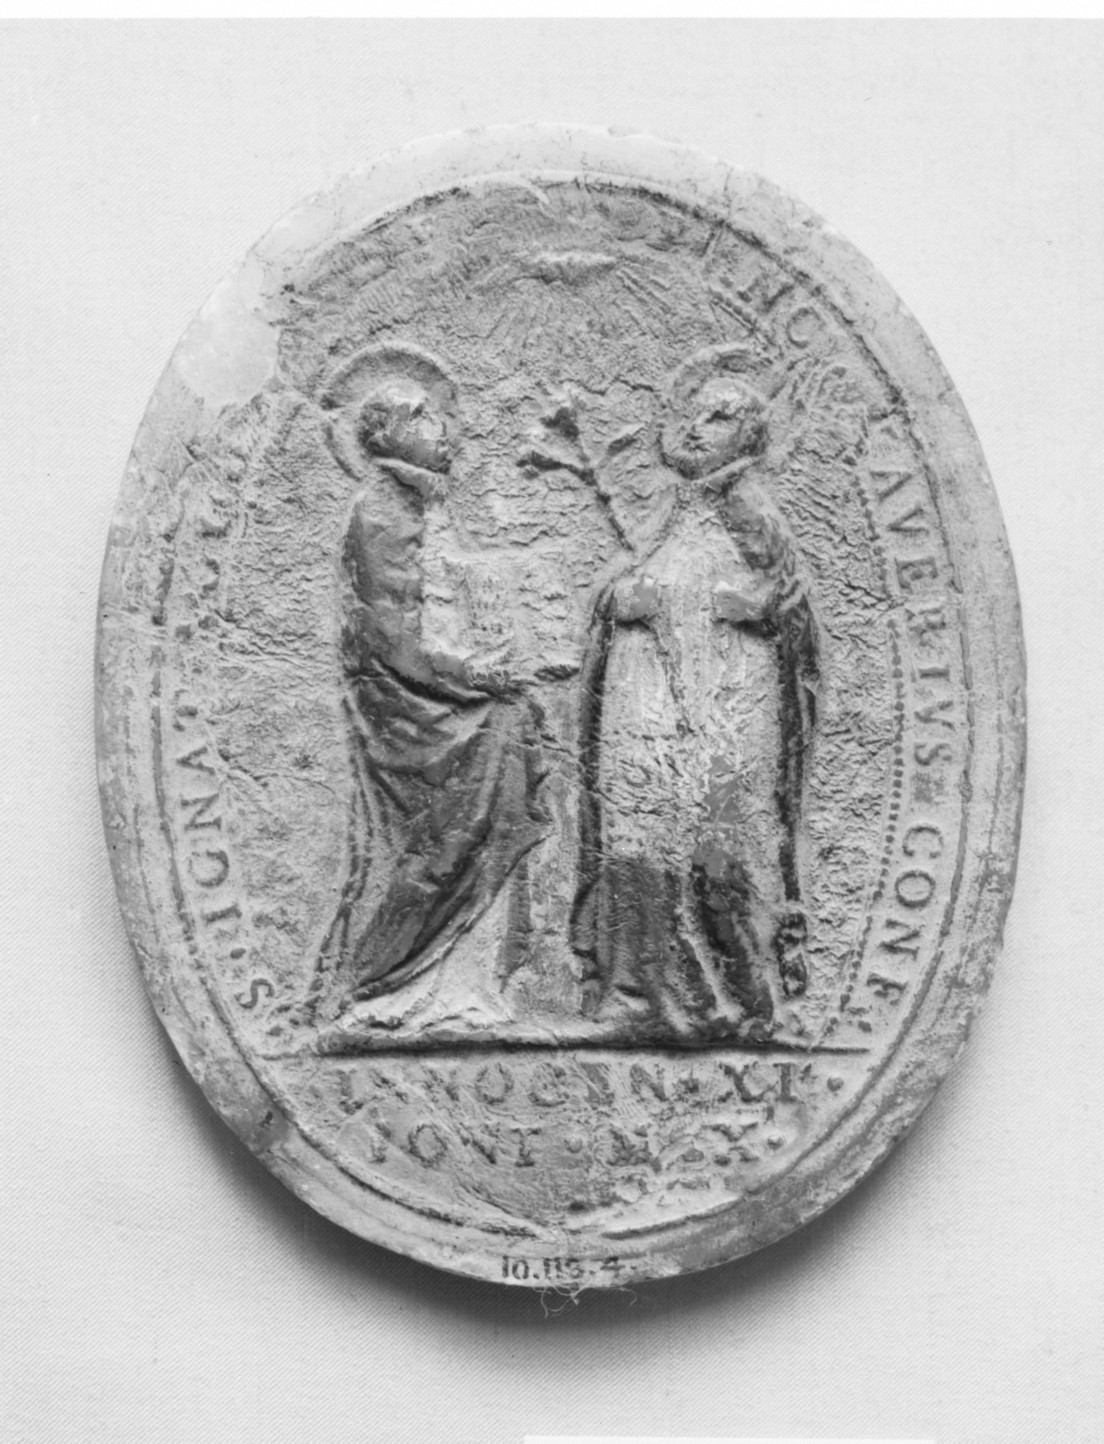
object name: medallion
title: Commemorating the two Jesuit Saints: Ignatius Loyola (Founder), and Francis Xavier (1506–1552) (greatest missionary)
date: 1677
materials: wax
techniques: painting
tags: saints